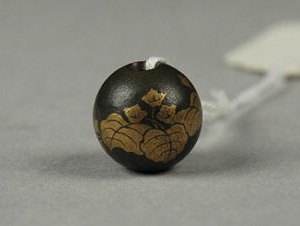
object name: ojime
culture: japanese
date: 1801-1900